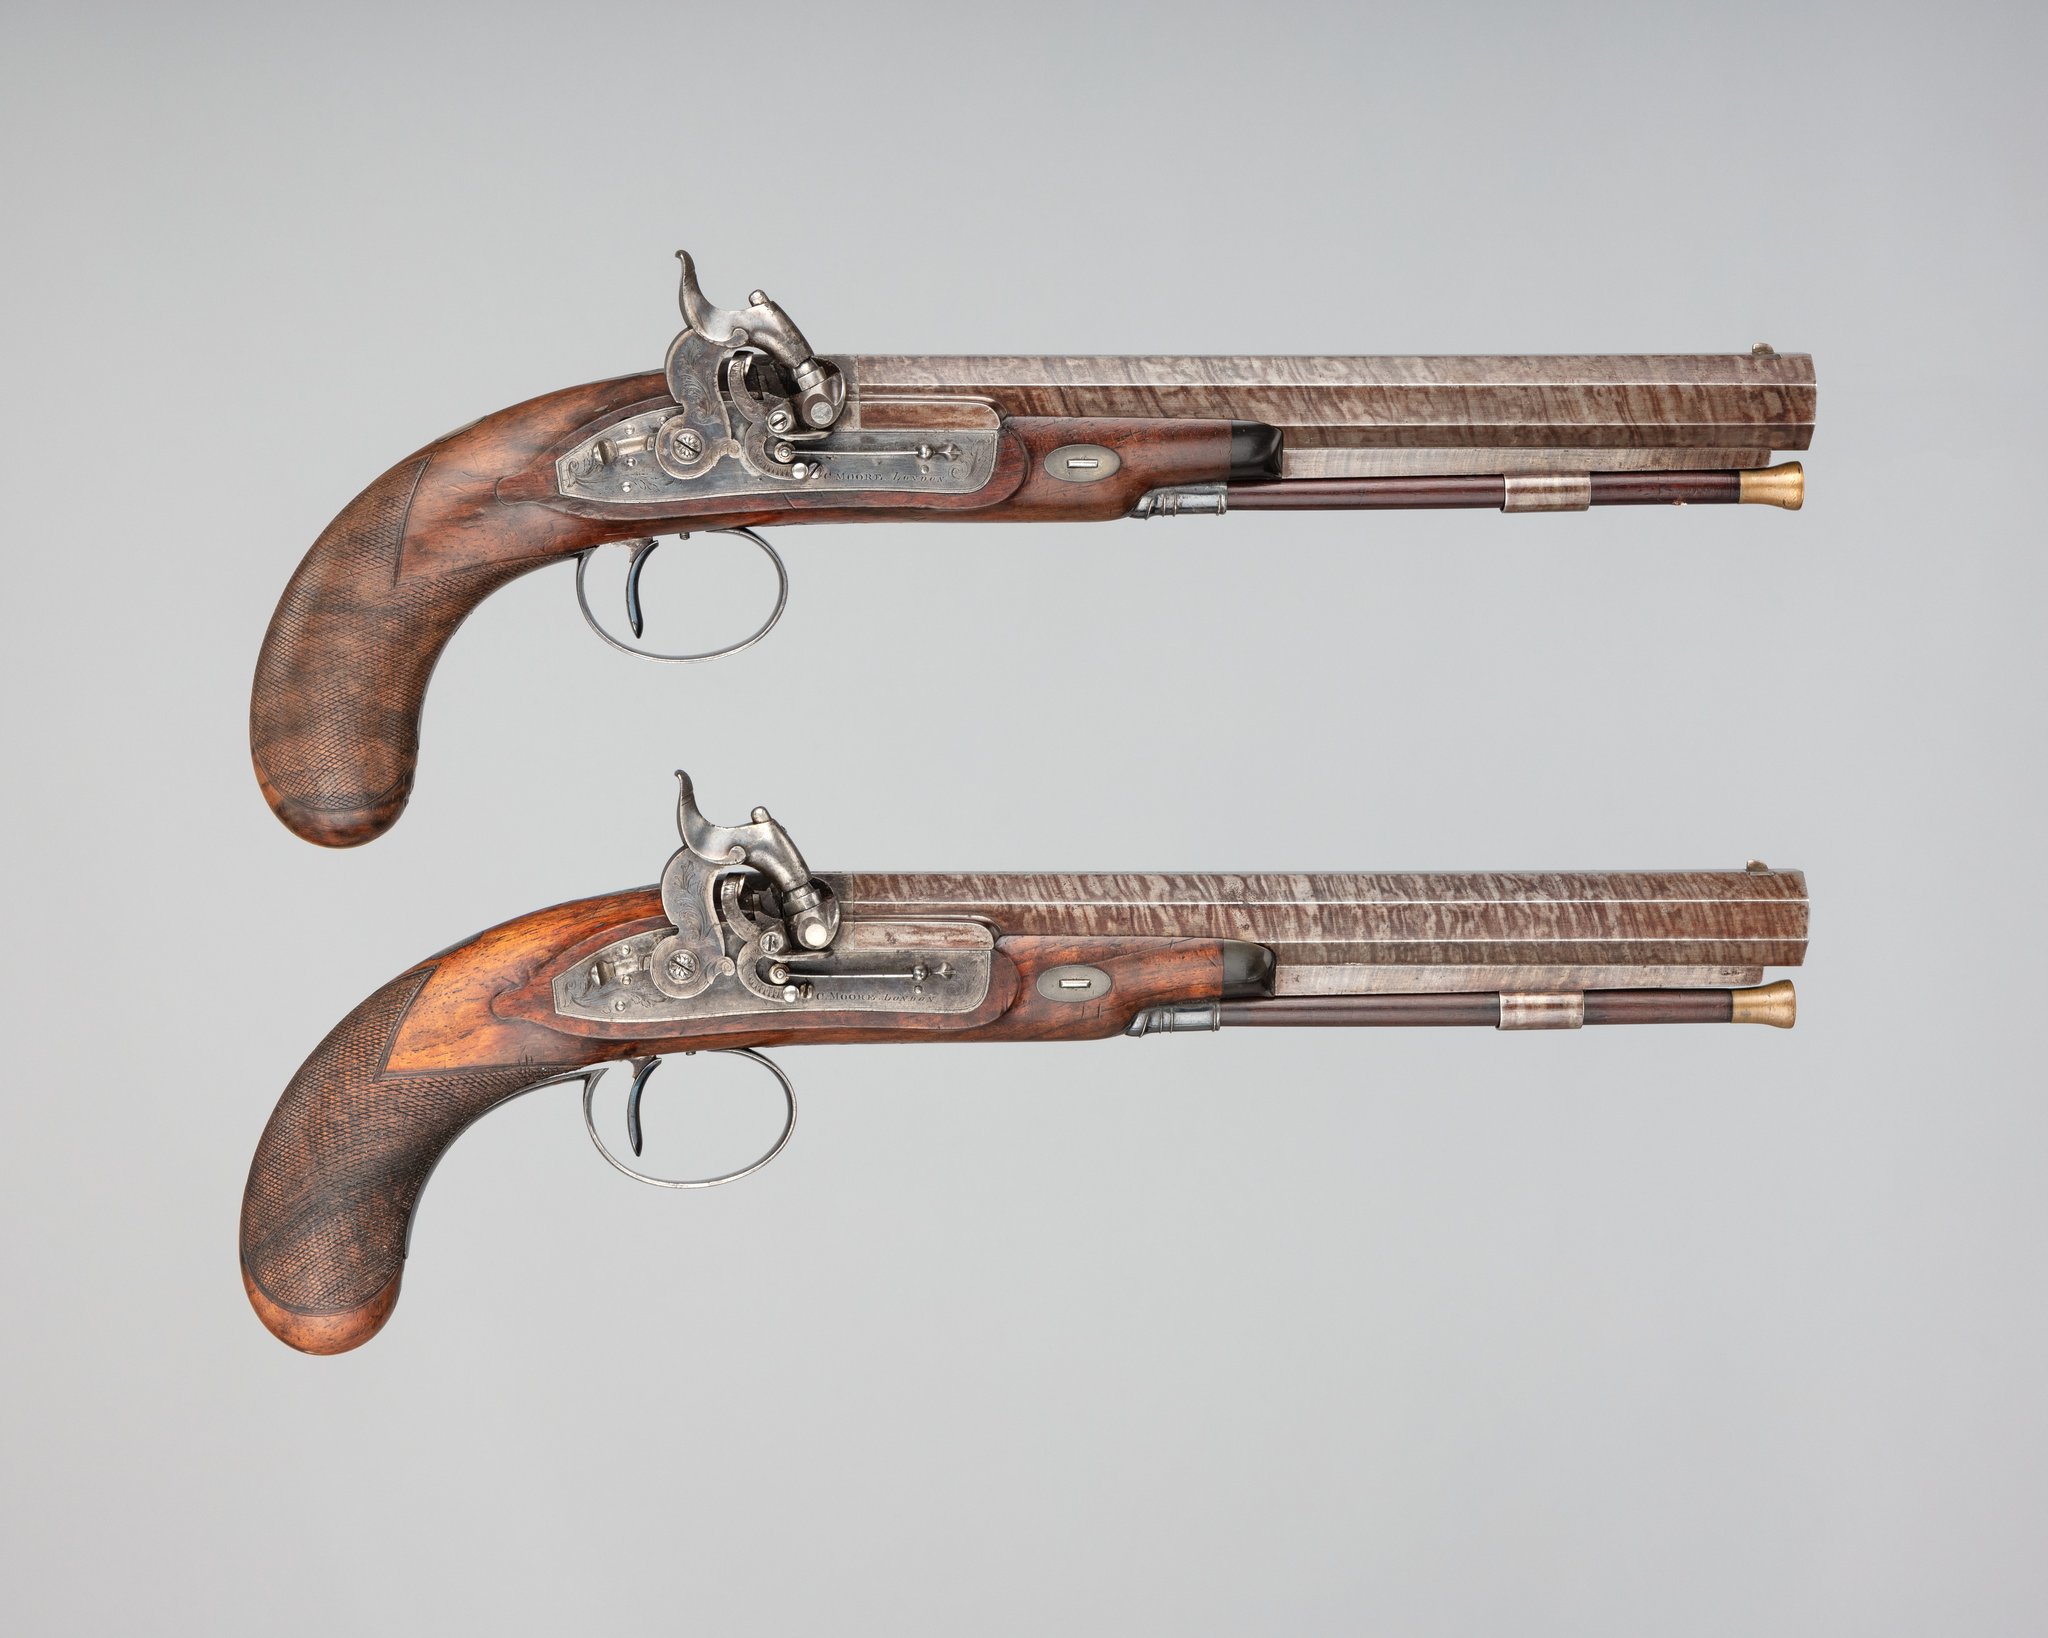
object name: detonator pistol with case and accessory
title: Pair of Pellet-Lock Pistols with Case with Accessories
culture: british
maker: charles moore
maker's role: gunsmith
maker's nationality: british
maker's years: 1796-1870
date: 1825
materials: bone, brass, bronze, paper, platinum, steel, textile, wood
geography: england